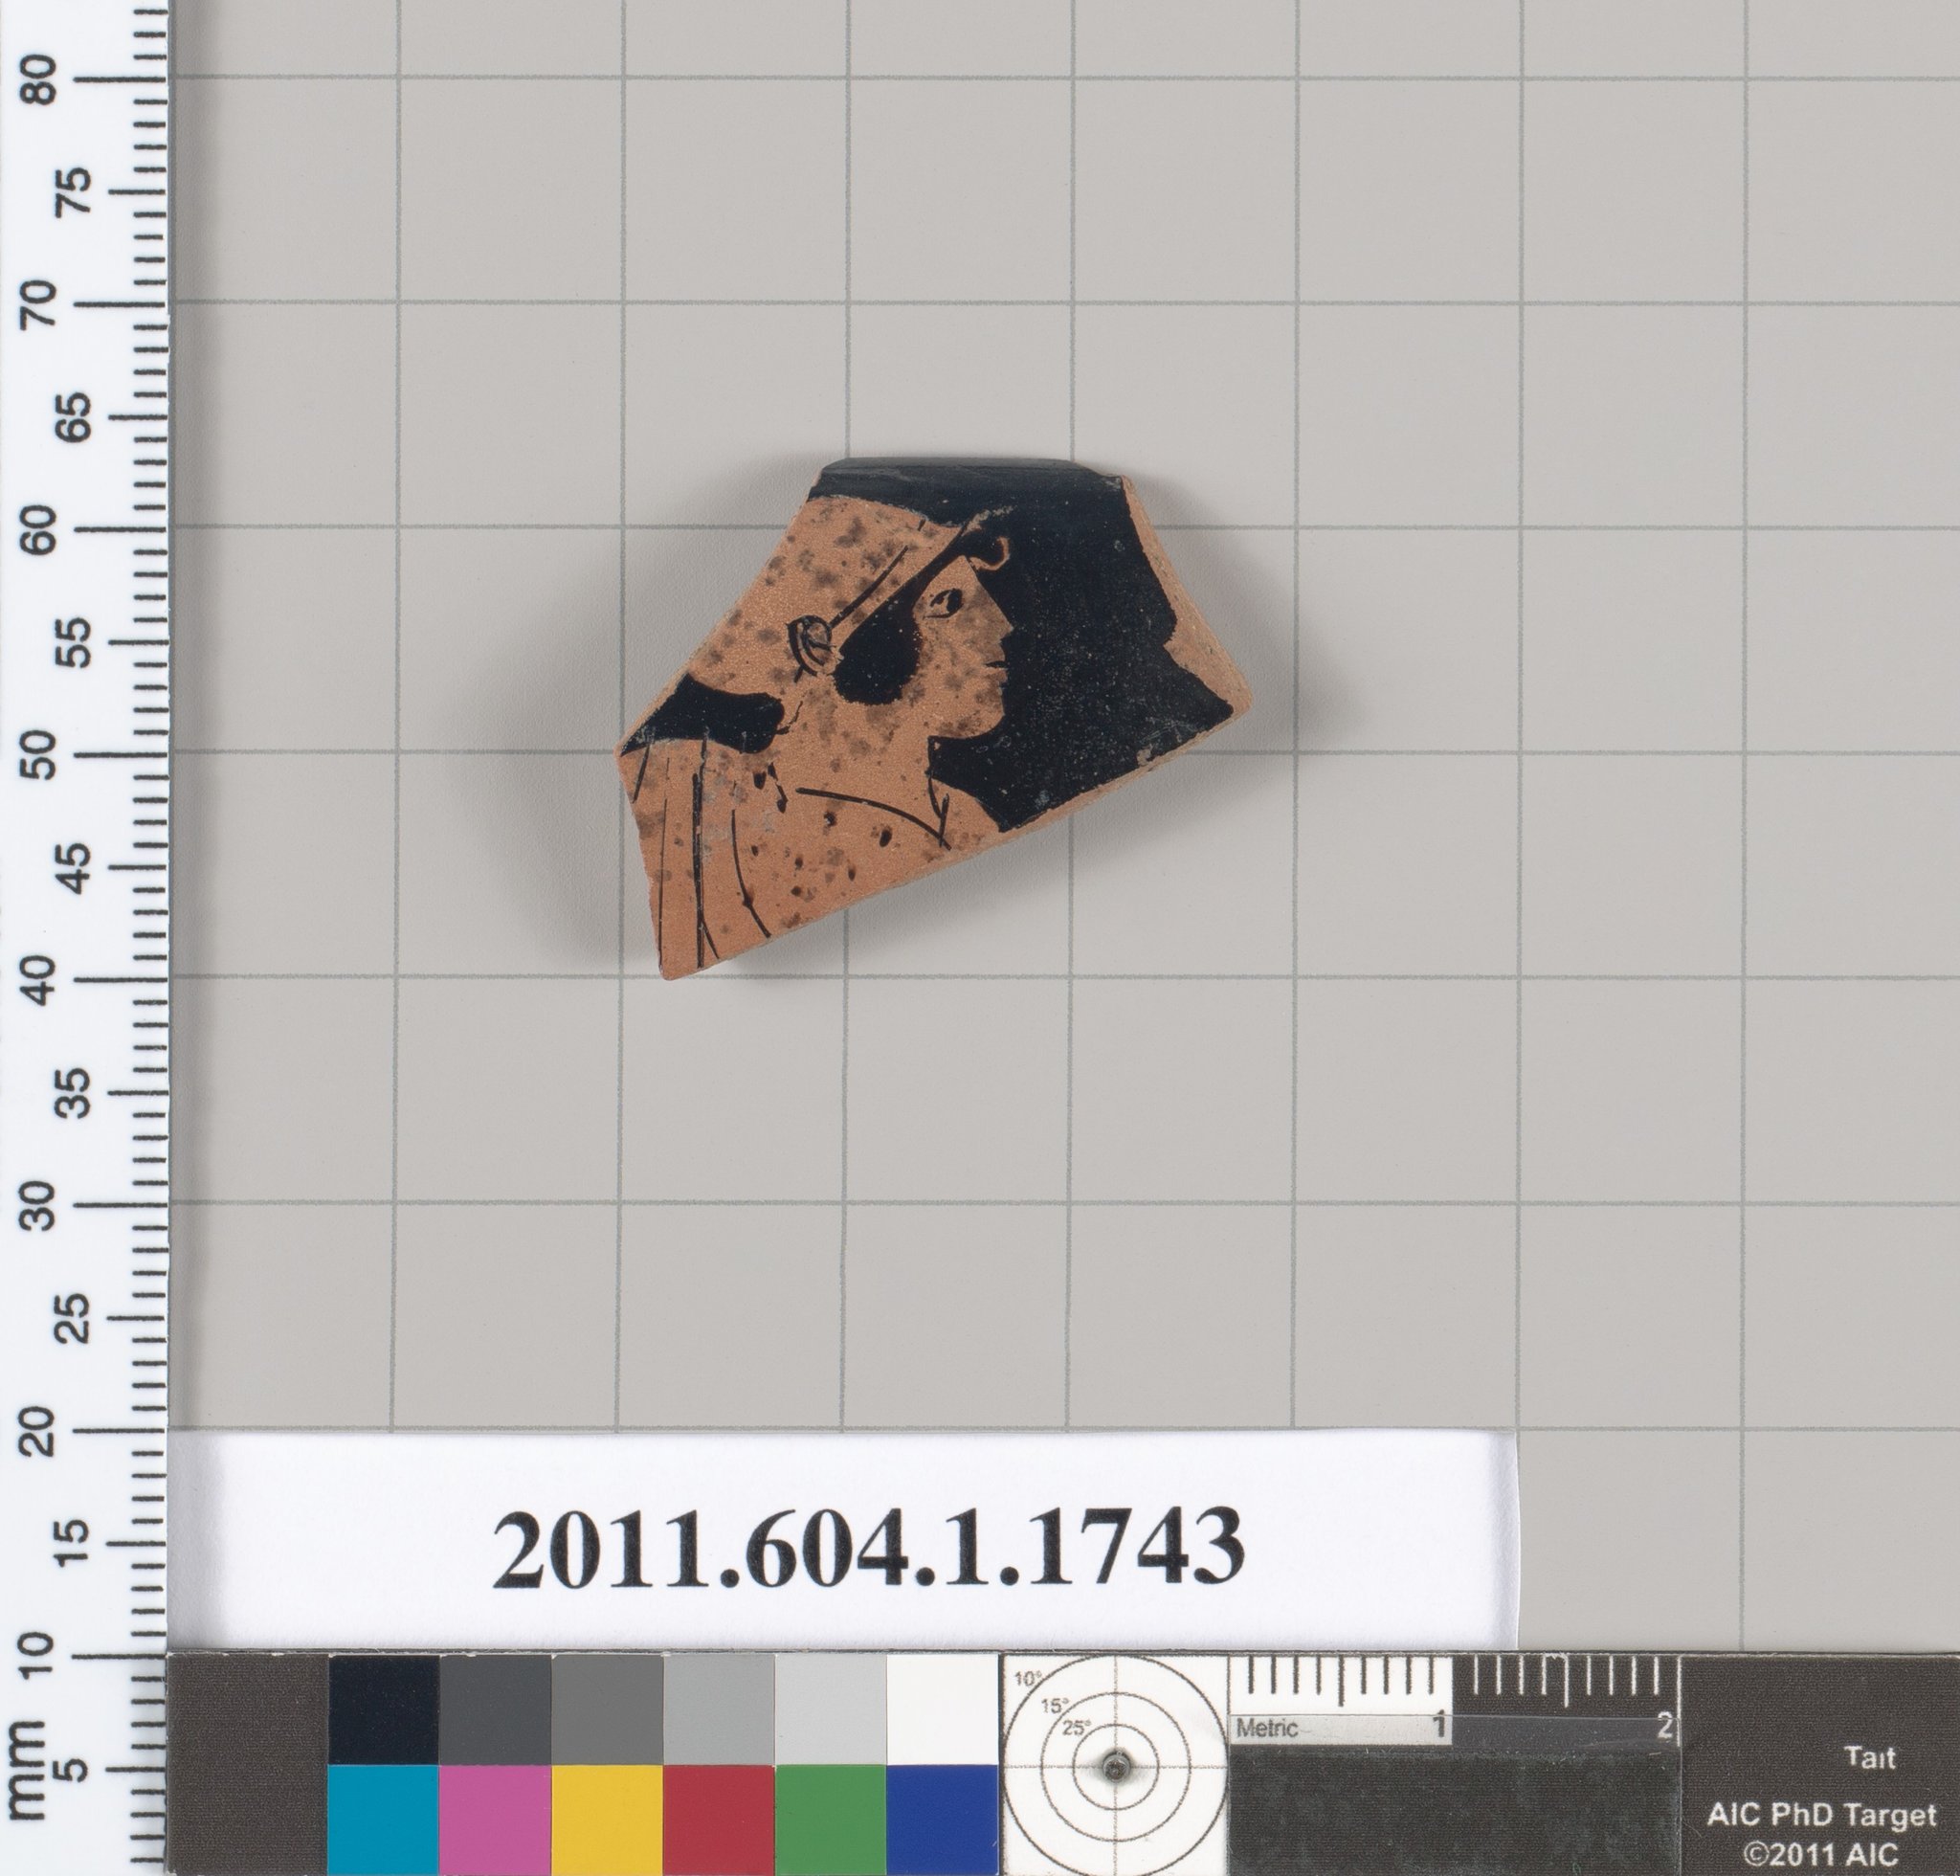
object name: kylix fragment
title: Terracotta rim fragment of a kylix (drinking cup)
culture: greek, attic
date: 475-451 BCE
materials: terracotta